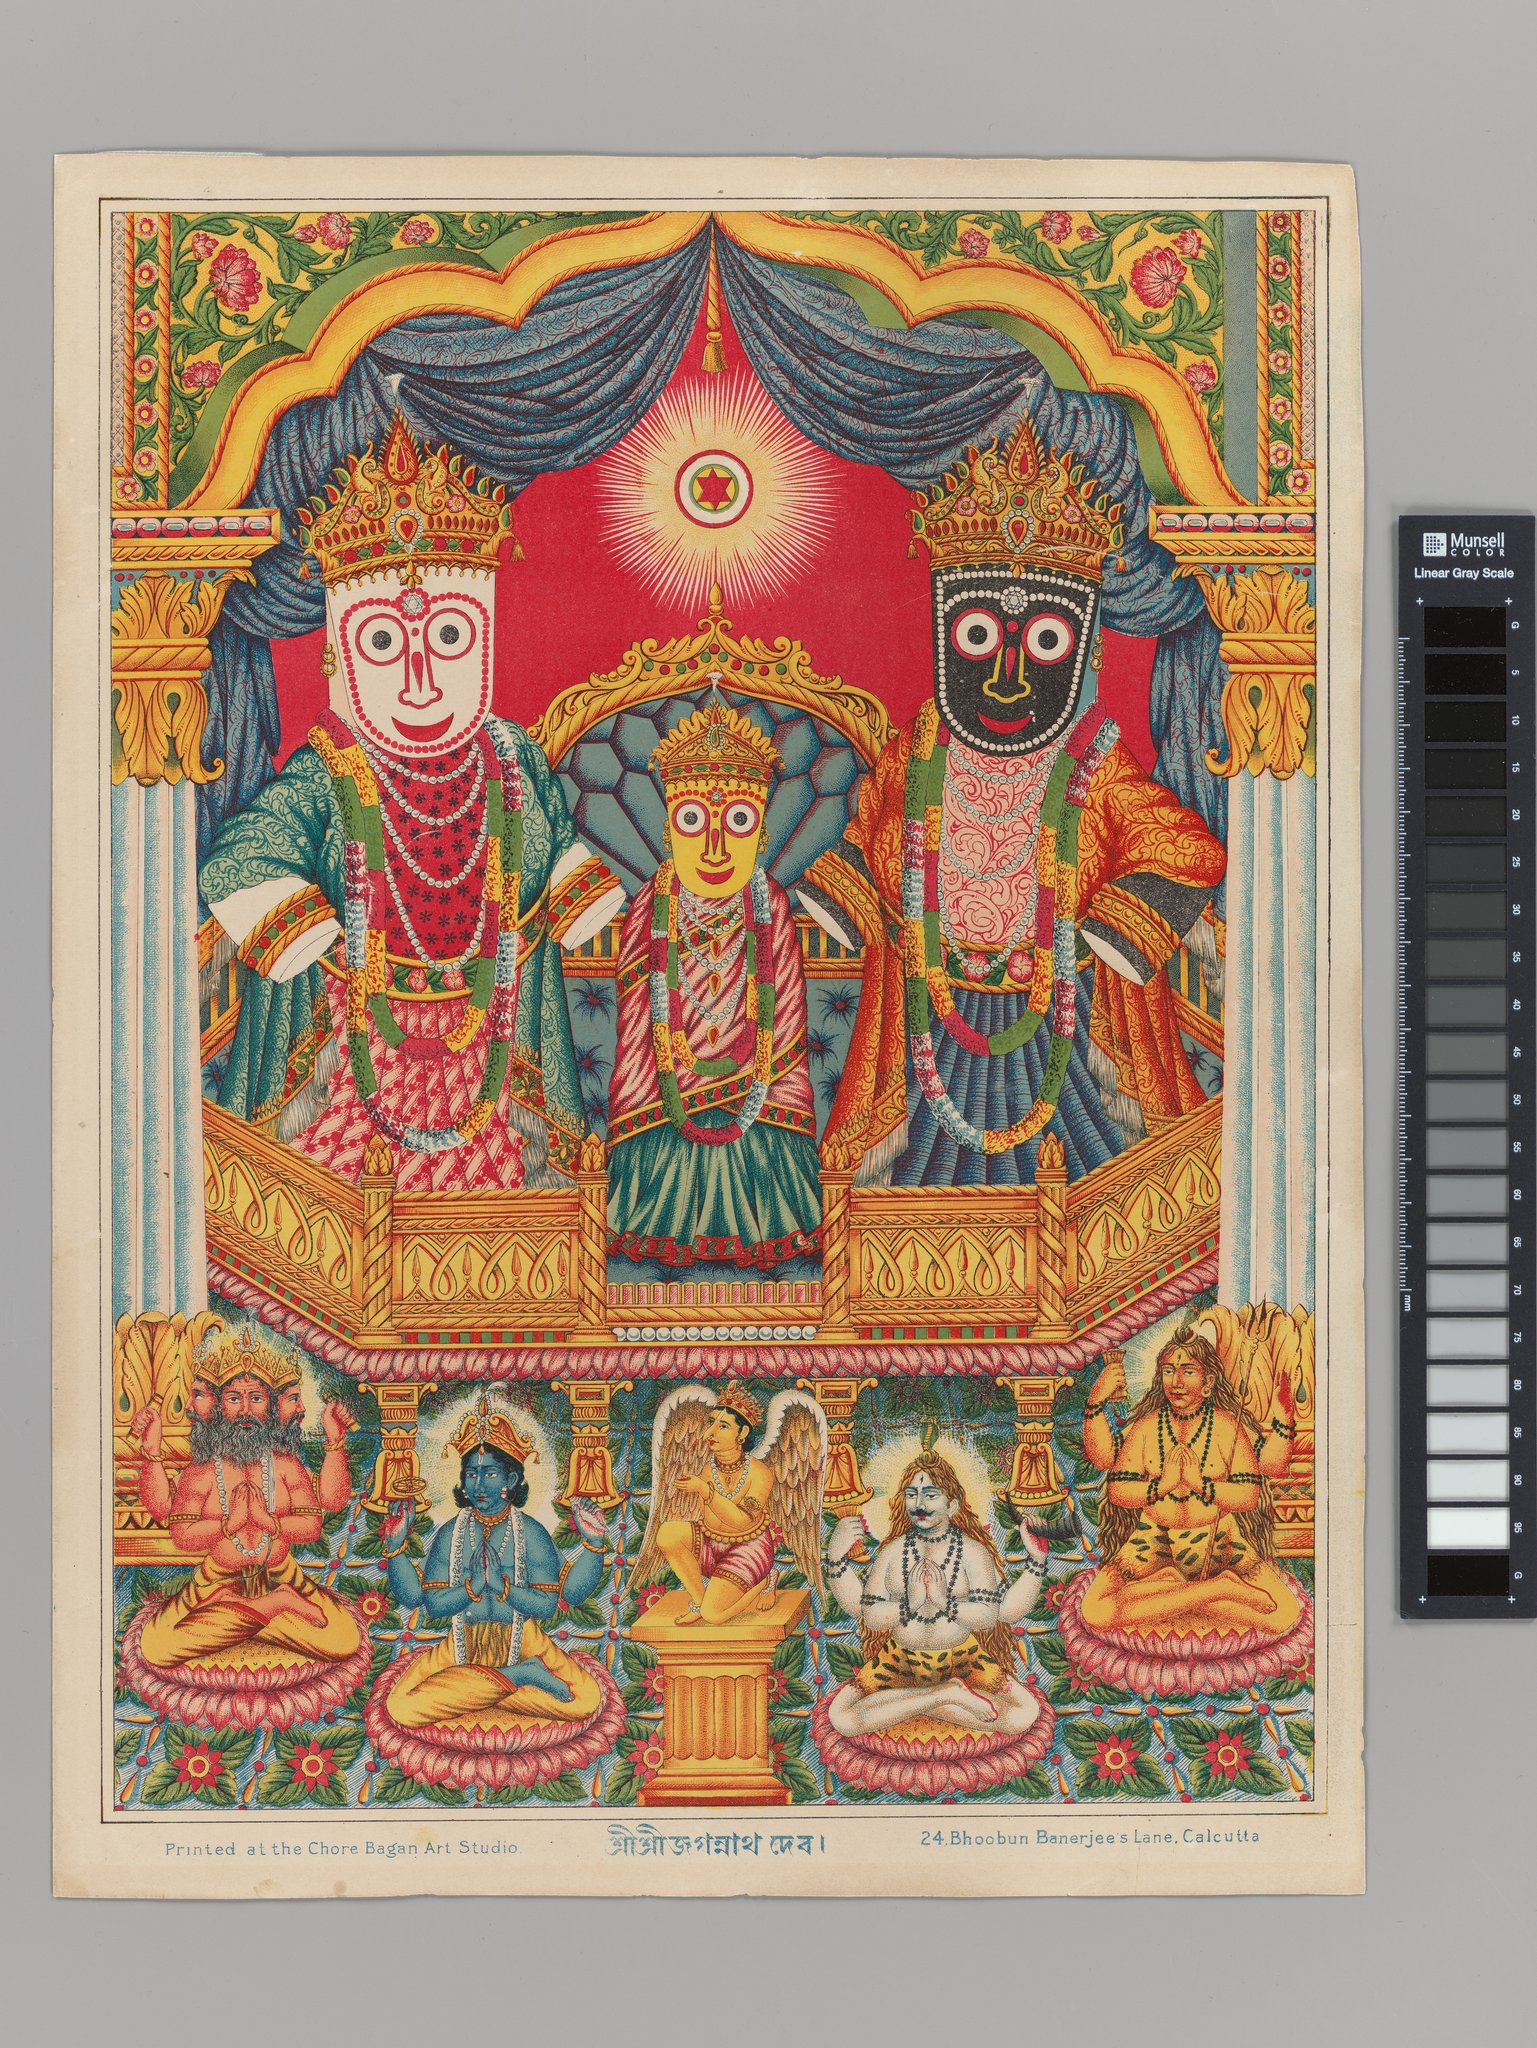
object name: print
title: Shri Shri Jagannatha (Krishna as the Lord of the World)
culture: indian or west bengali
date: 1890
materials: chromolithograph, paper